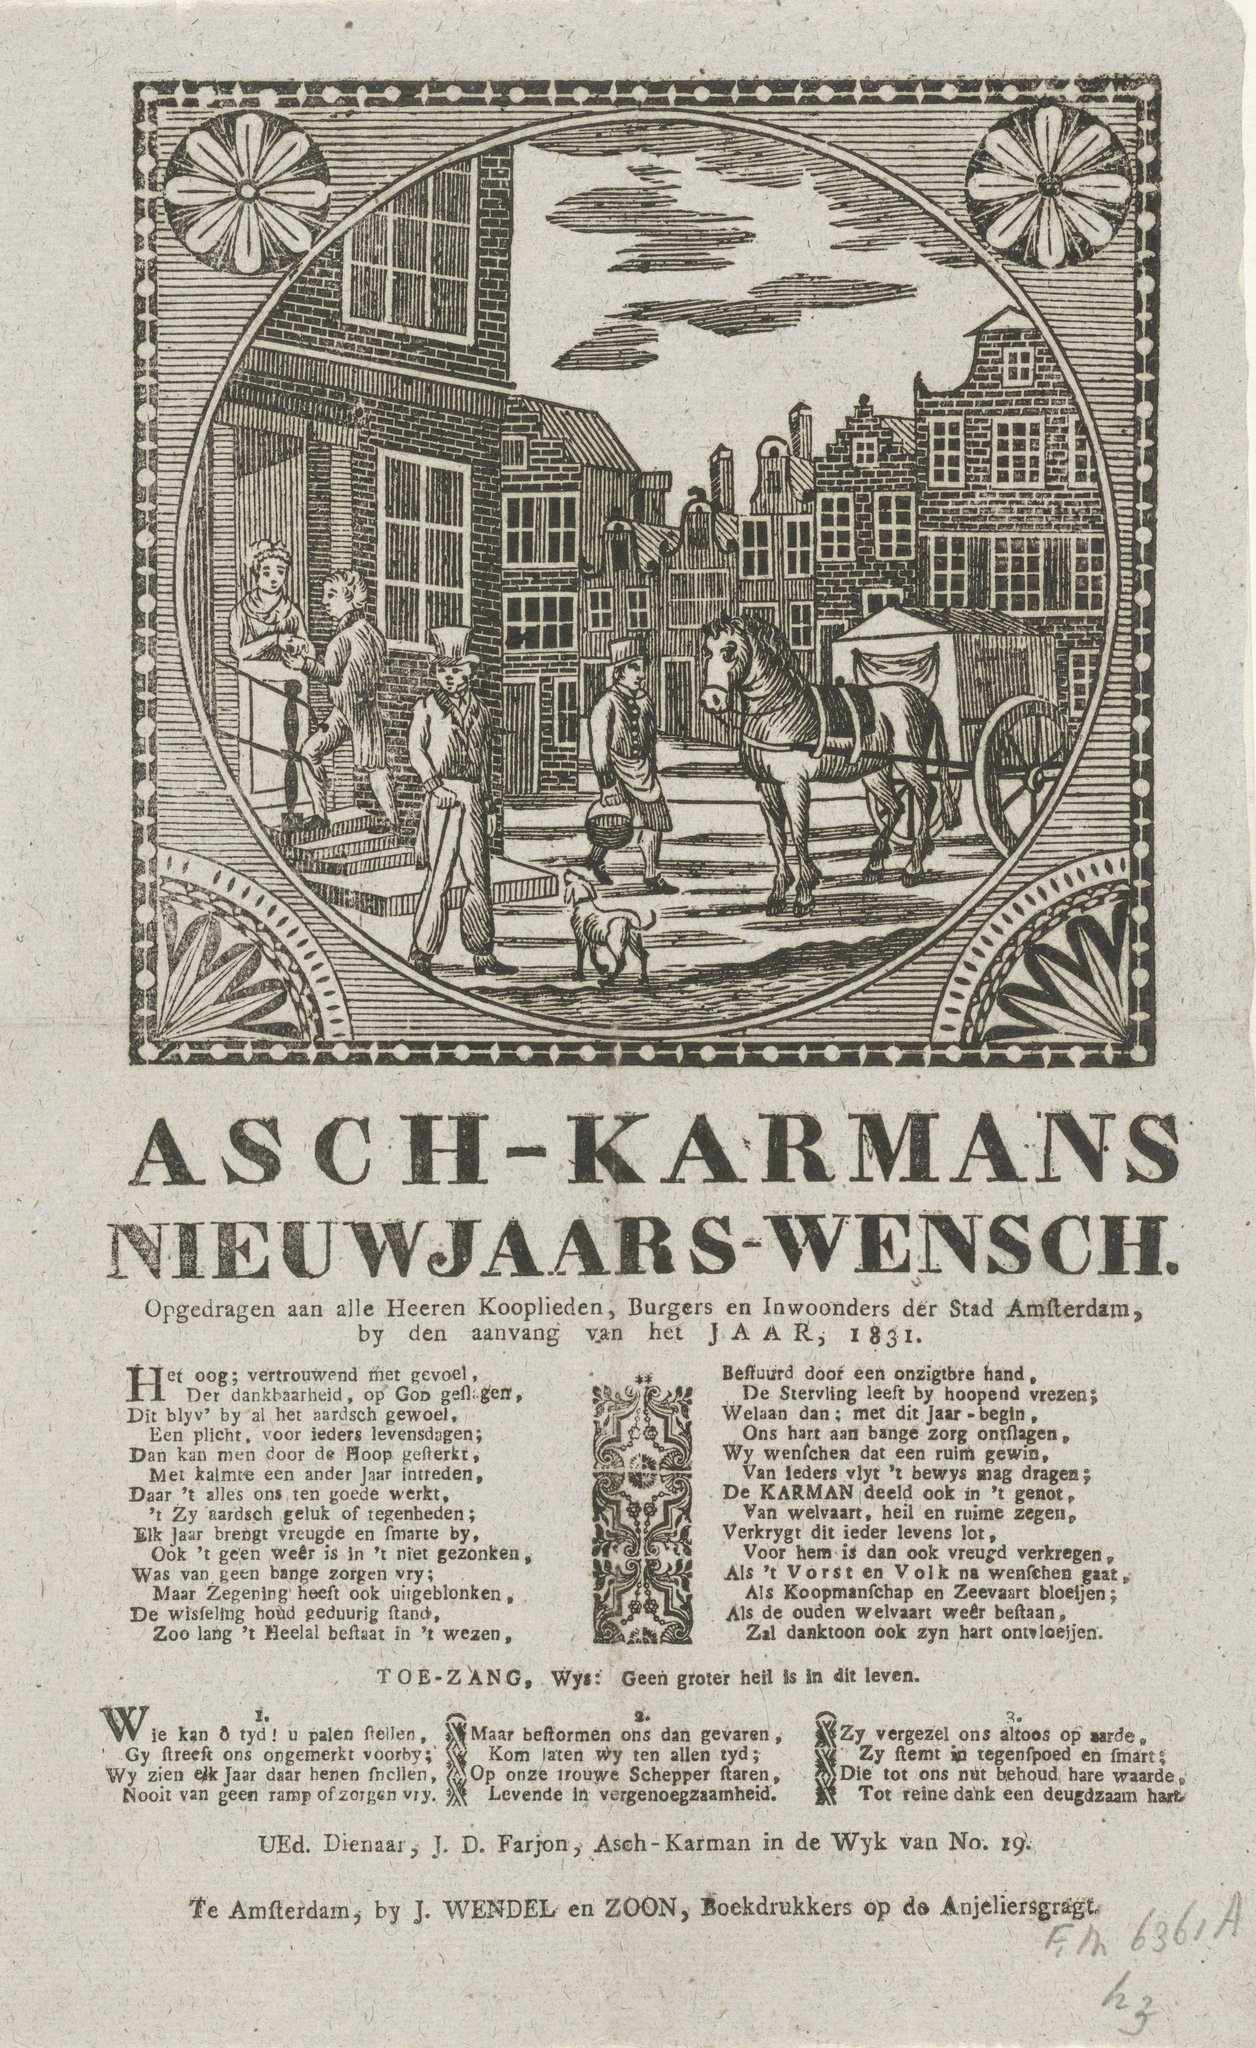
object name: print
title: Asch-Karmans Nieuwjaars-Wensch (...) 1831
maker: Anonymous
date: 1830-1831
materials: paper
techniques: letterpress printing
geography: amsterdam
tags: public road - ii - ideal city, garbage collection, amsterdam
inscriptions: collector's mark: Lugt 2228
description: Nieuwjaarswens namens de askarrenmannen (karrenman of vuilnisman) te Amsterdam voor het jaar 1831. Gezicht in een straat te Amsterdam waar een man asemmers naar de kar draagt terwijl een andere man aan huis geld ophaalt. Onderaan een gedicht in twee kolommen en een lied in drie verzen. Namens J.D. Farjon, de askarreman van wijk no. 19.